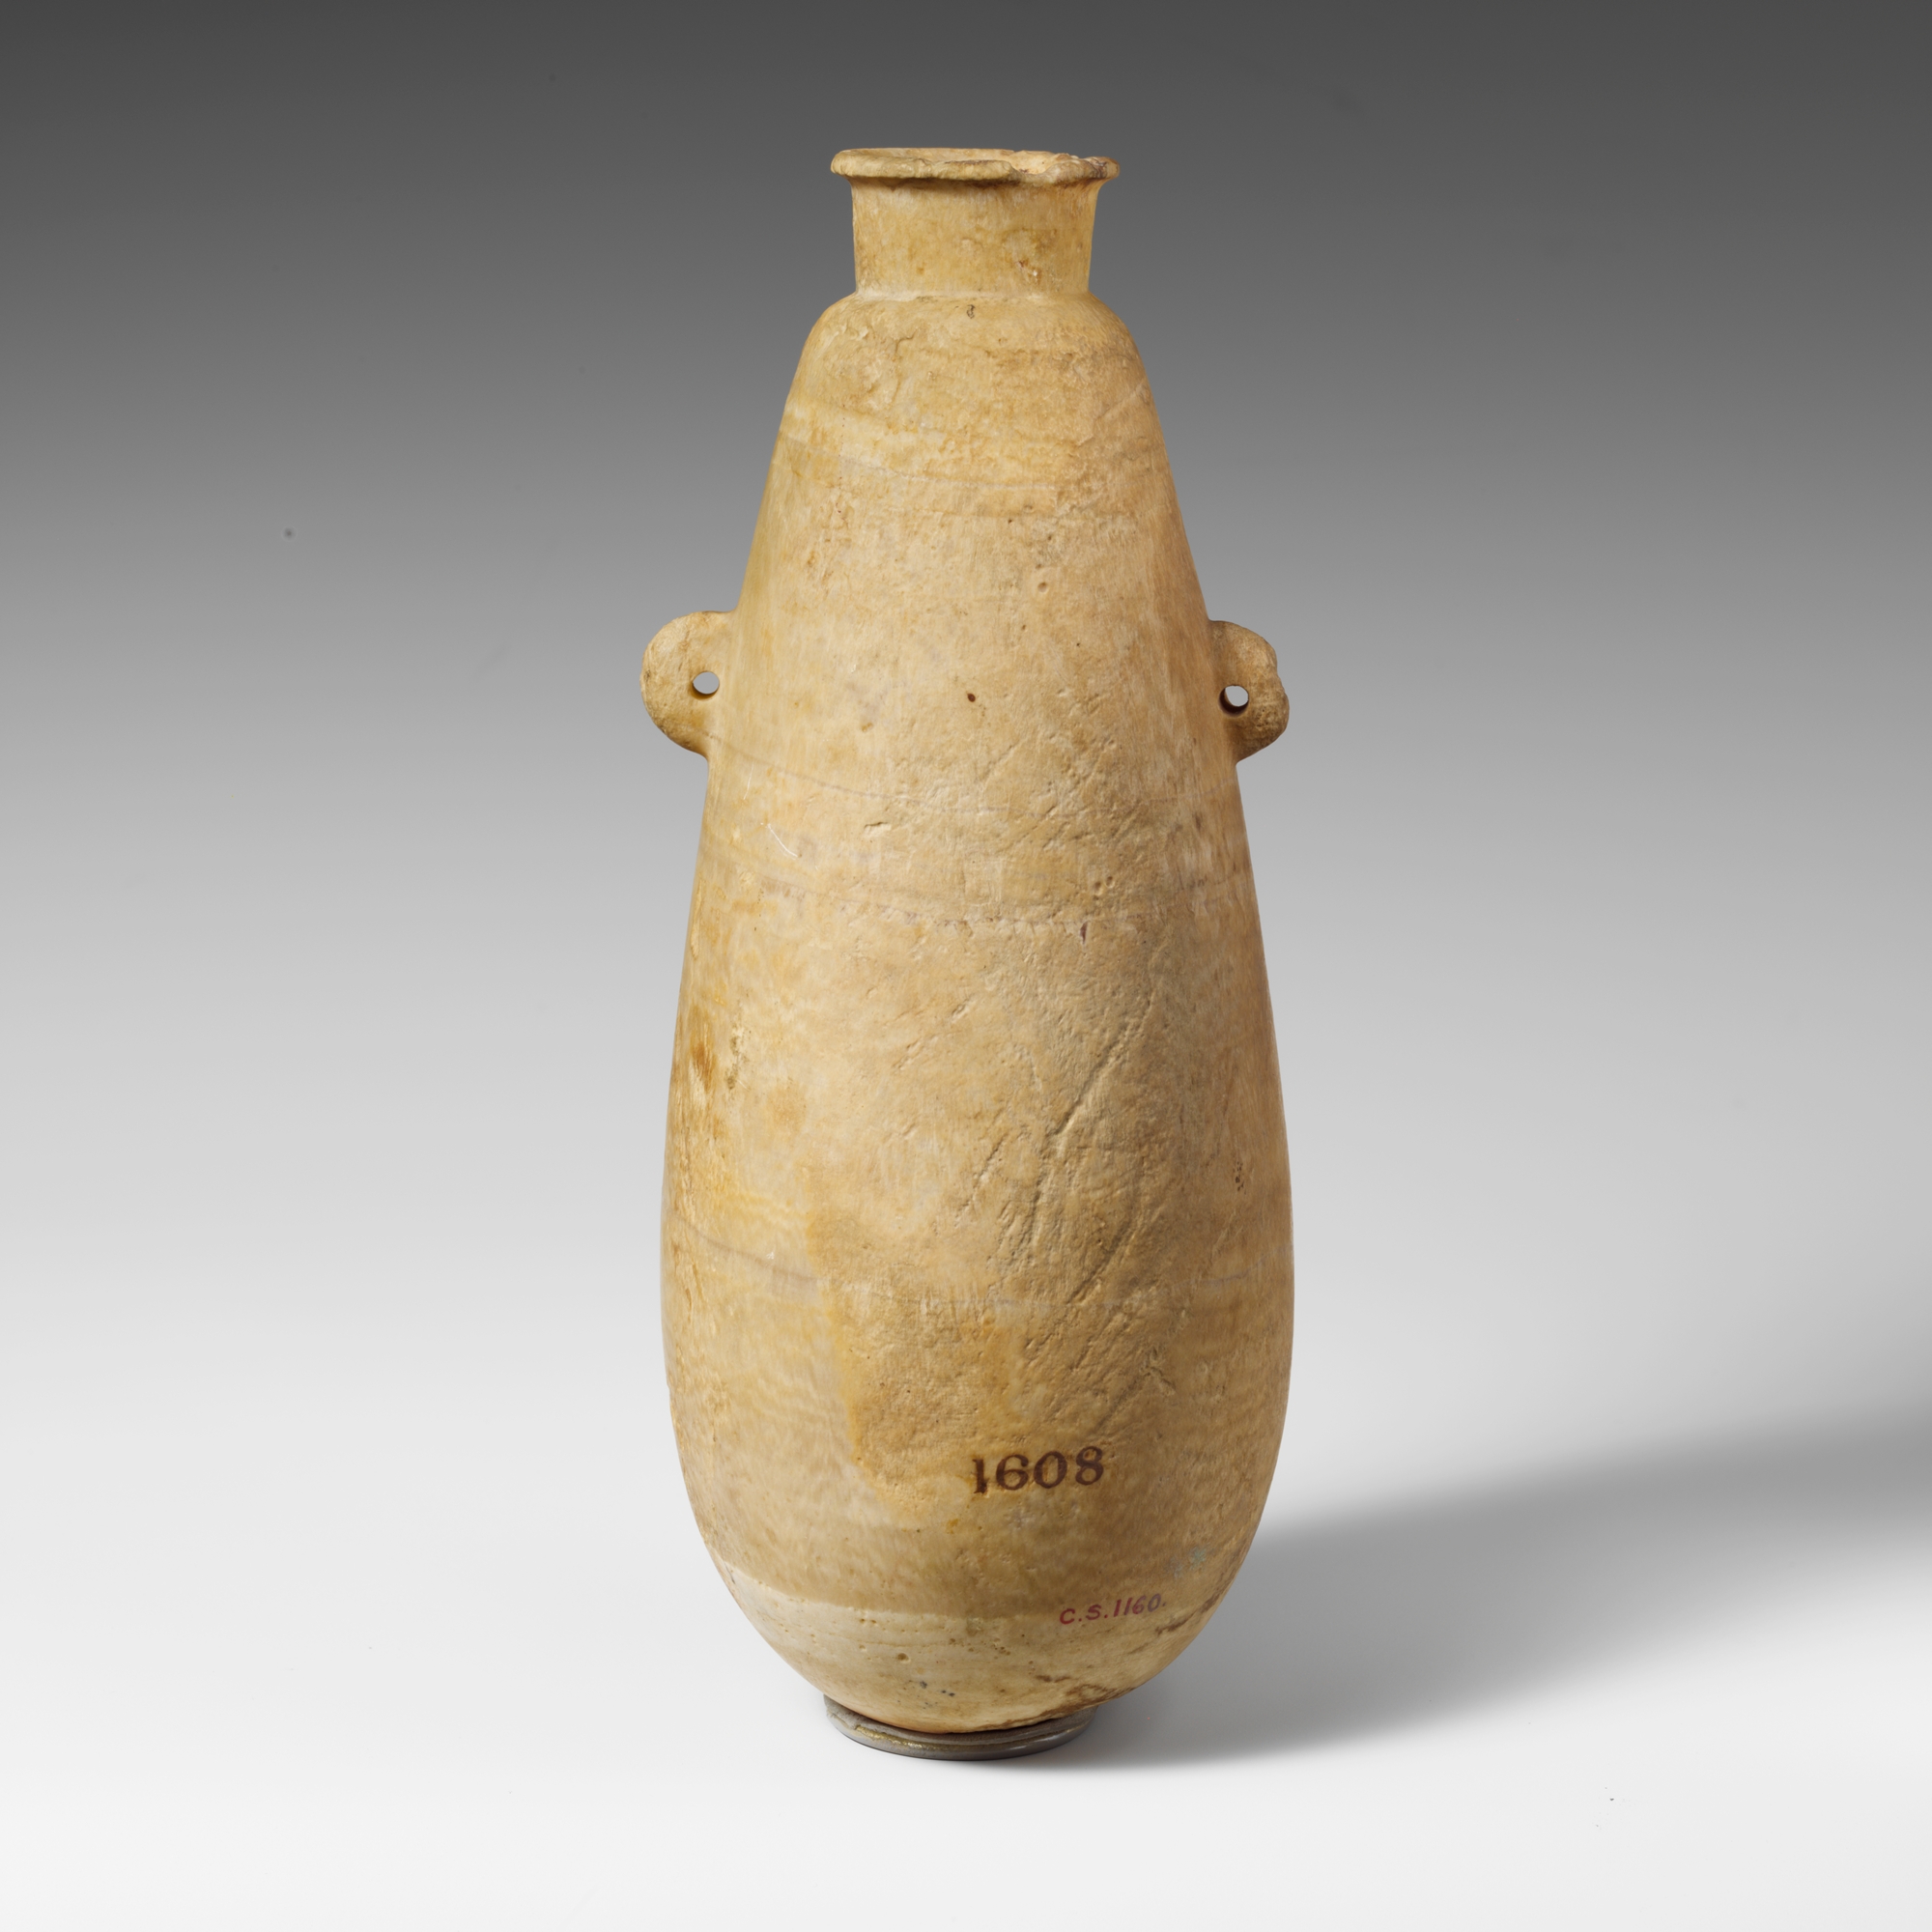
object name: alabastron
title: Alabaster alabastron (perfume vase)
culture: cypriot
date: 600-401 BCE